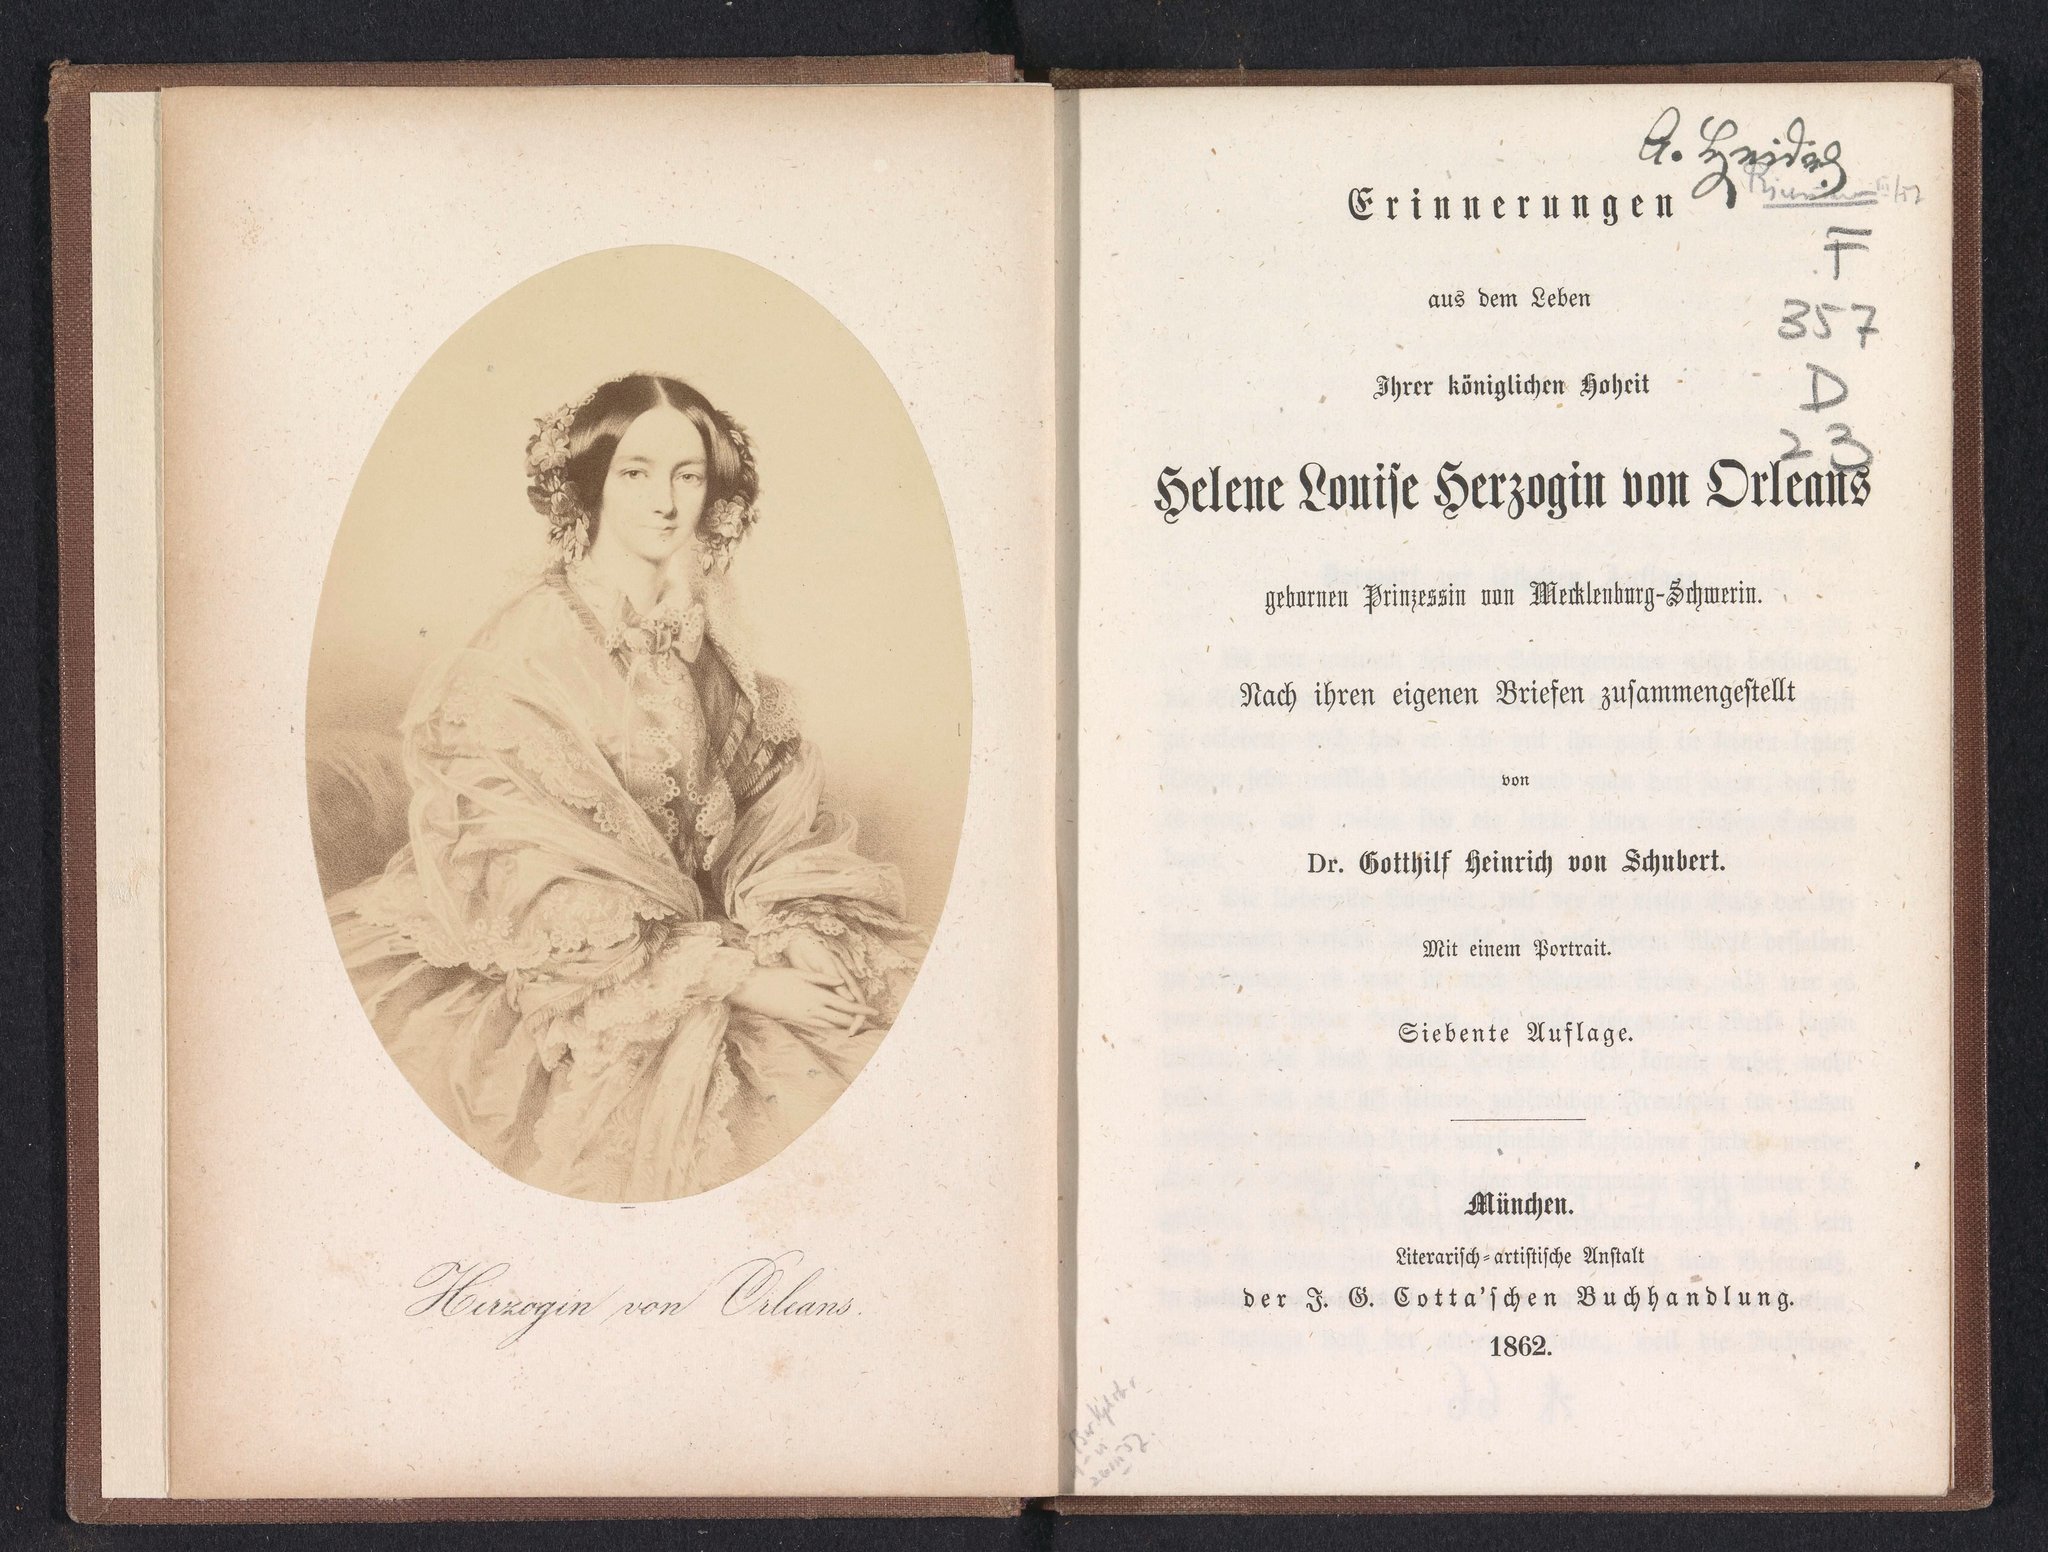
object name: photograph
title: Fotoreproductie van een schilderij, voorstellende een portret van Helene Luise Elisabeth zu Mecklenburg-Schwerin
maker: Anonymous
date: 1857-1862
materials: photographic support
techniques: albumen print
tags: helene van mecklenburg-schwerin, adult woman